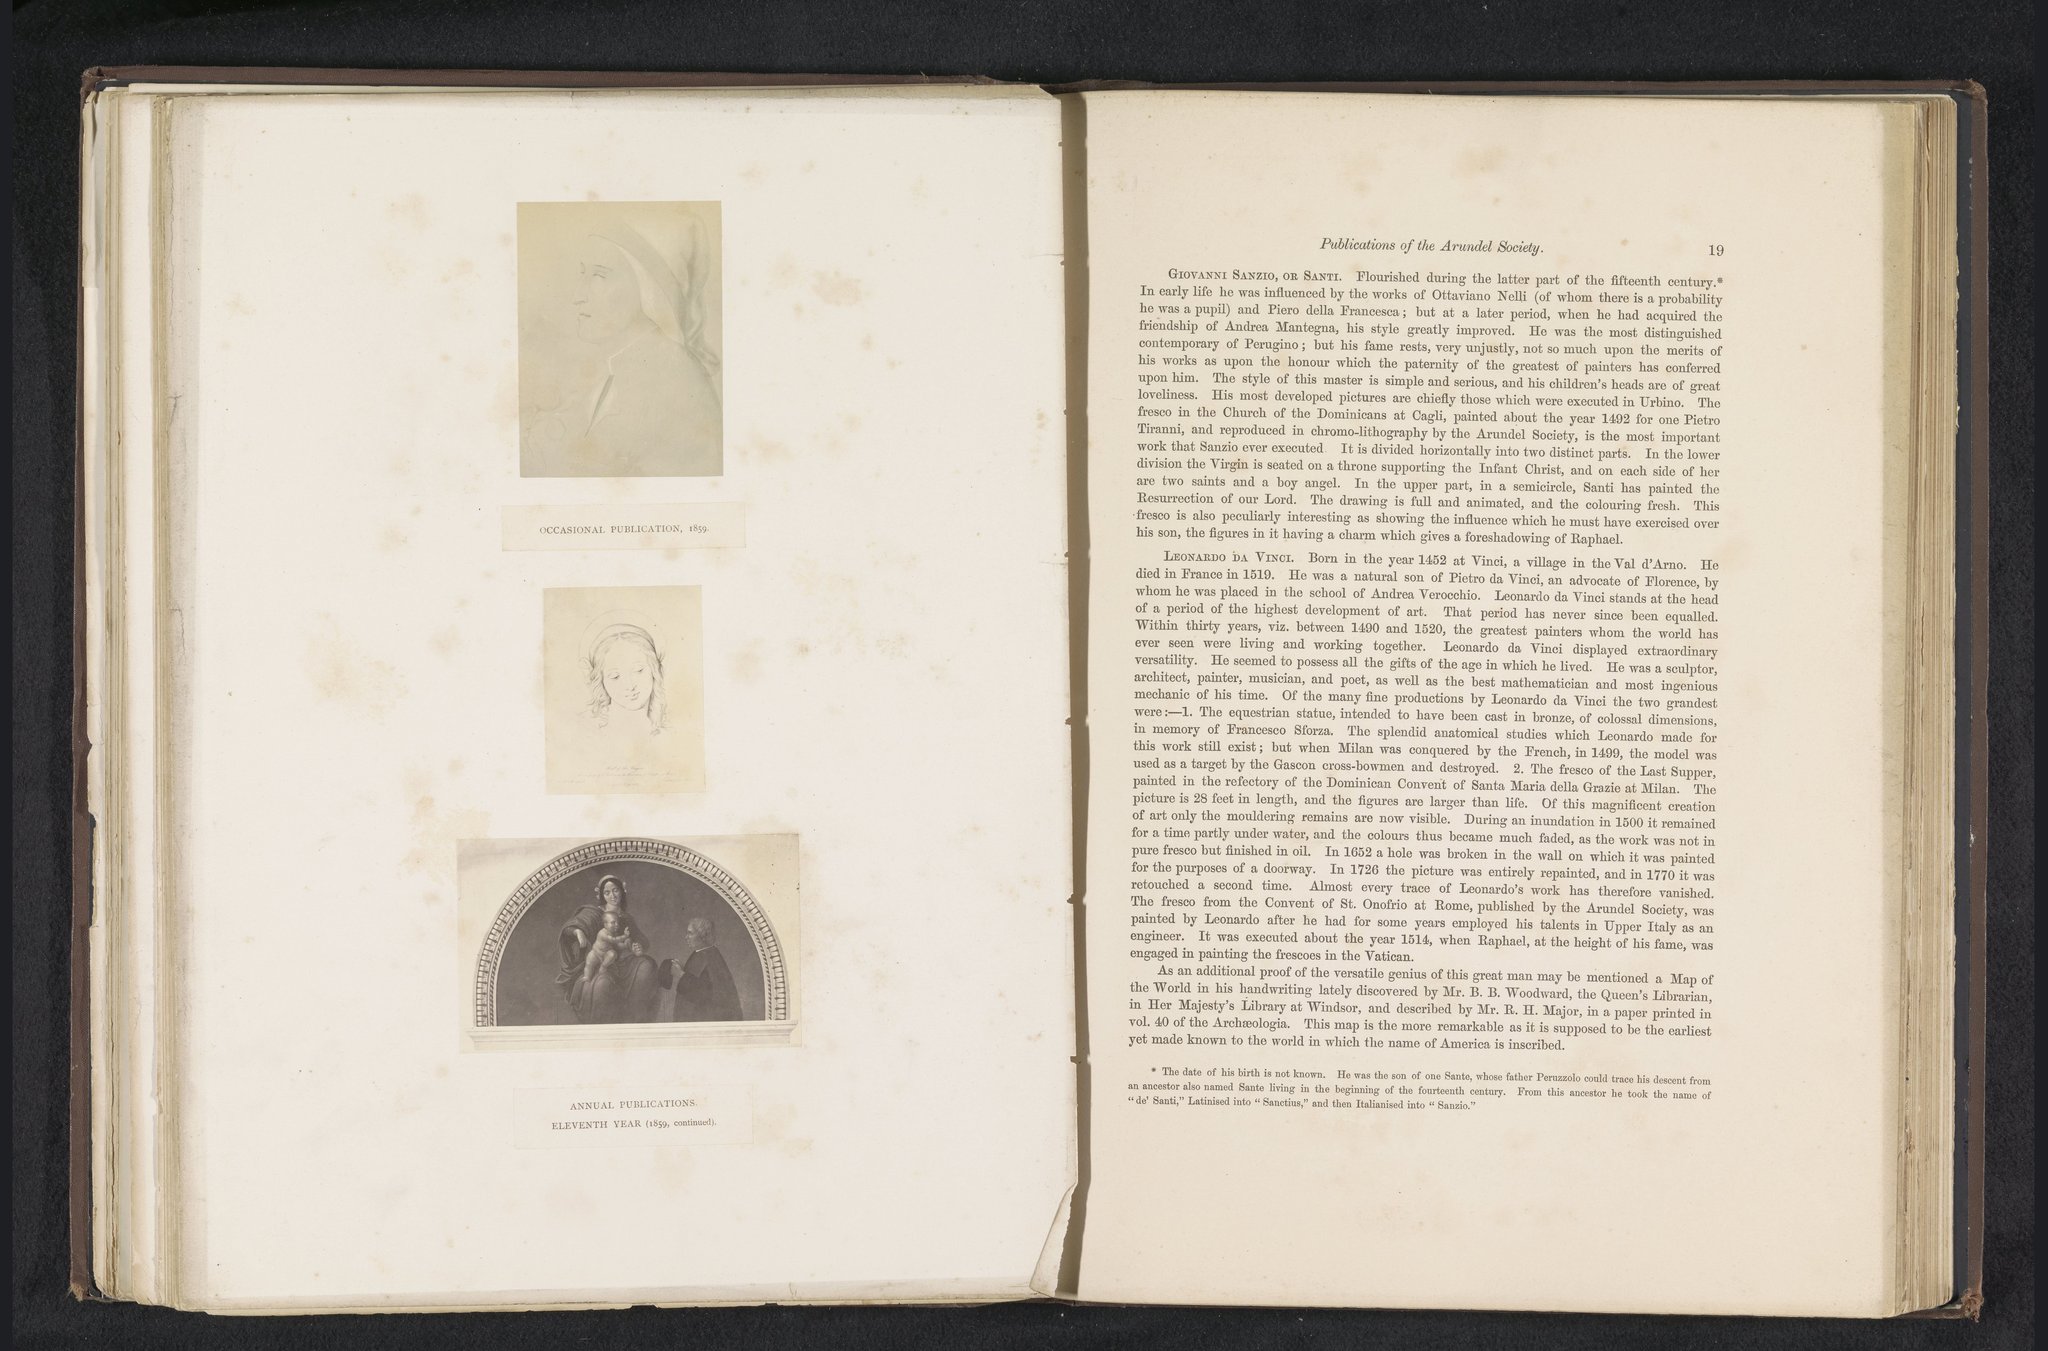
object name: photograph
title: Drie fotoreproducties van een publicatie door de Arundel Society met een schilderij van Maria met Kind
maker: Anonymous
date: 1859-1869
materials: photographic support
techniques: albumen print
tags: madonna: i.e. mary with the christ-child, book, painting (including book-illumination, miniature-painting)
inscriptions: inscription: ‘Annual publications, eleventh year (1859, continued).’